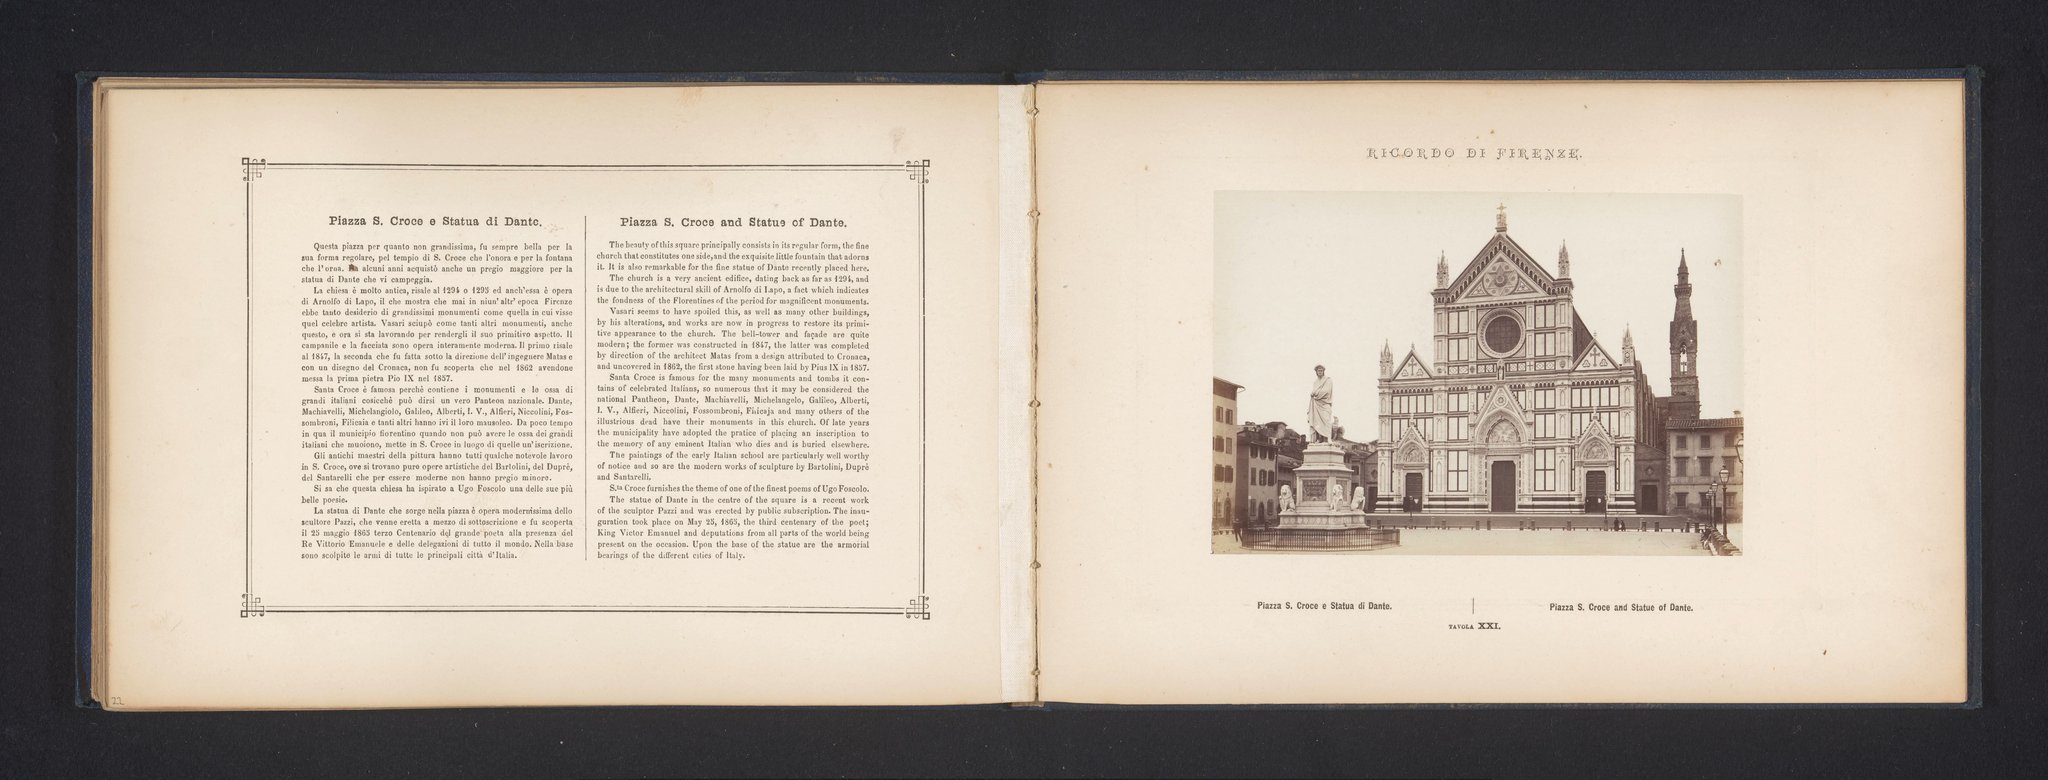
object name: photograph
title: Piazza S. Croce e Statua di Dante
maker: giacomo brogi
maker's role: fotograaf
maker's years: 1822-1881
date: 1861-1871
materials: photographic support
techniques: albumen print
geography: piazza santa croce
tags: square, place, circus, etc., church (exterior), monument, statue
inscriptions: number: ‘Tavola XXI.’